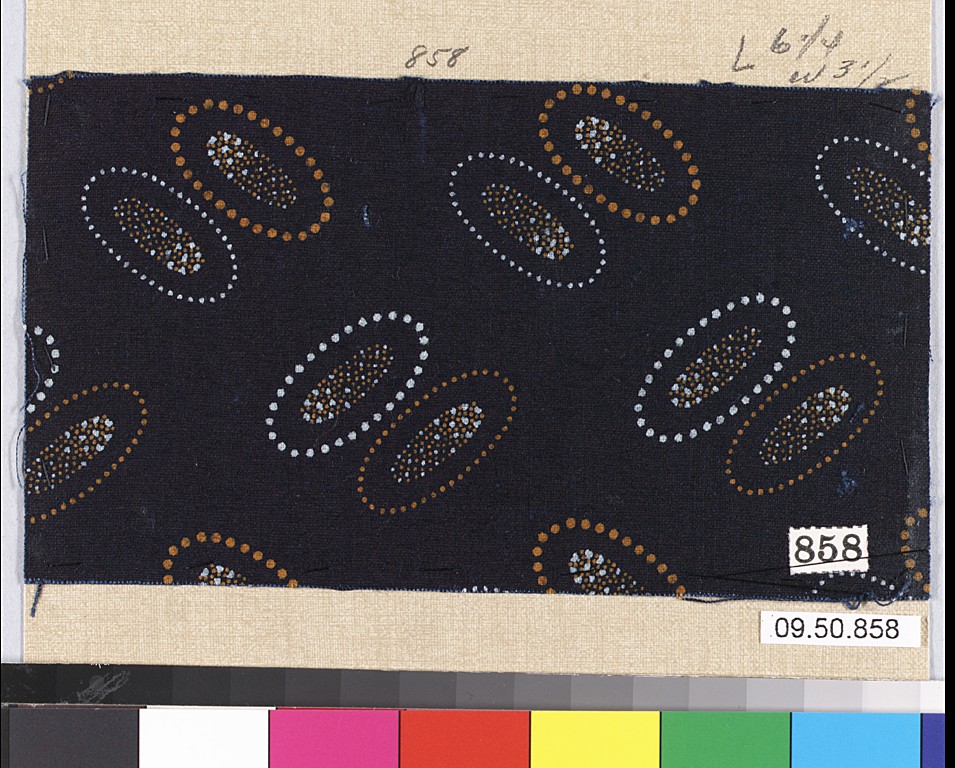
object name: piece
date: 1801-1900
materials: cotton